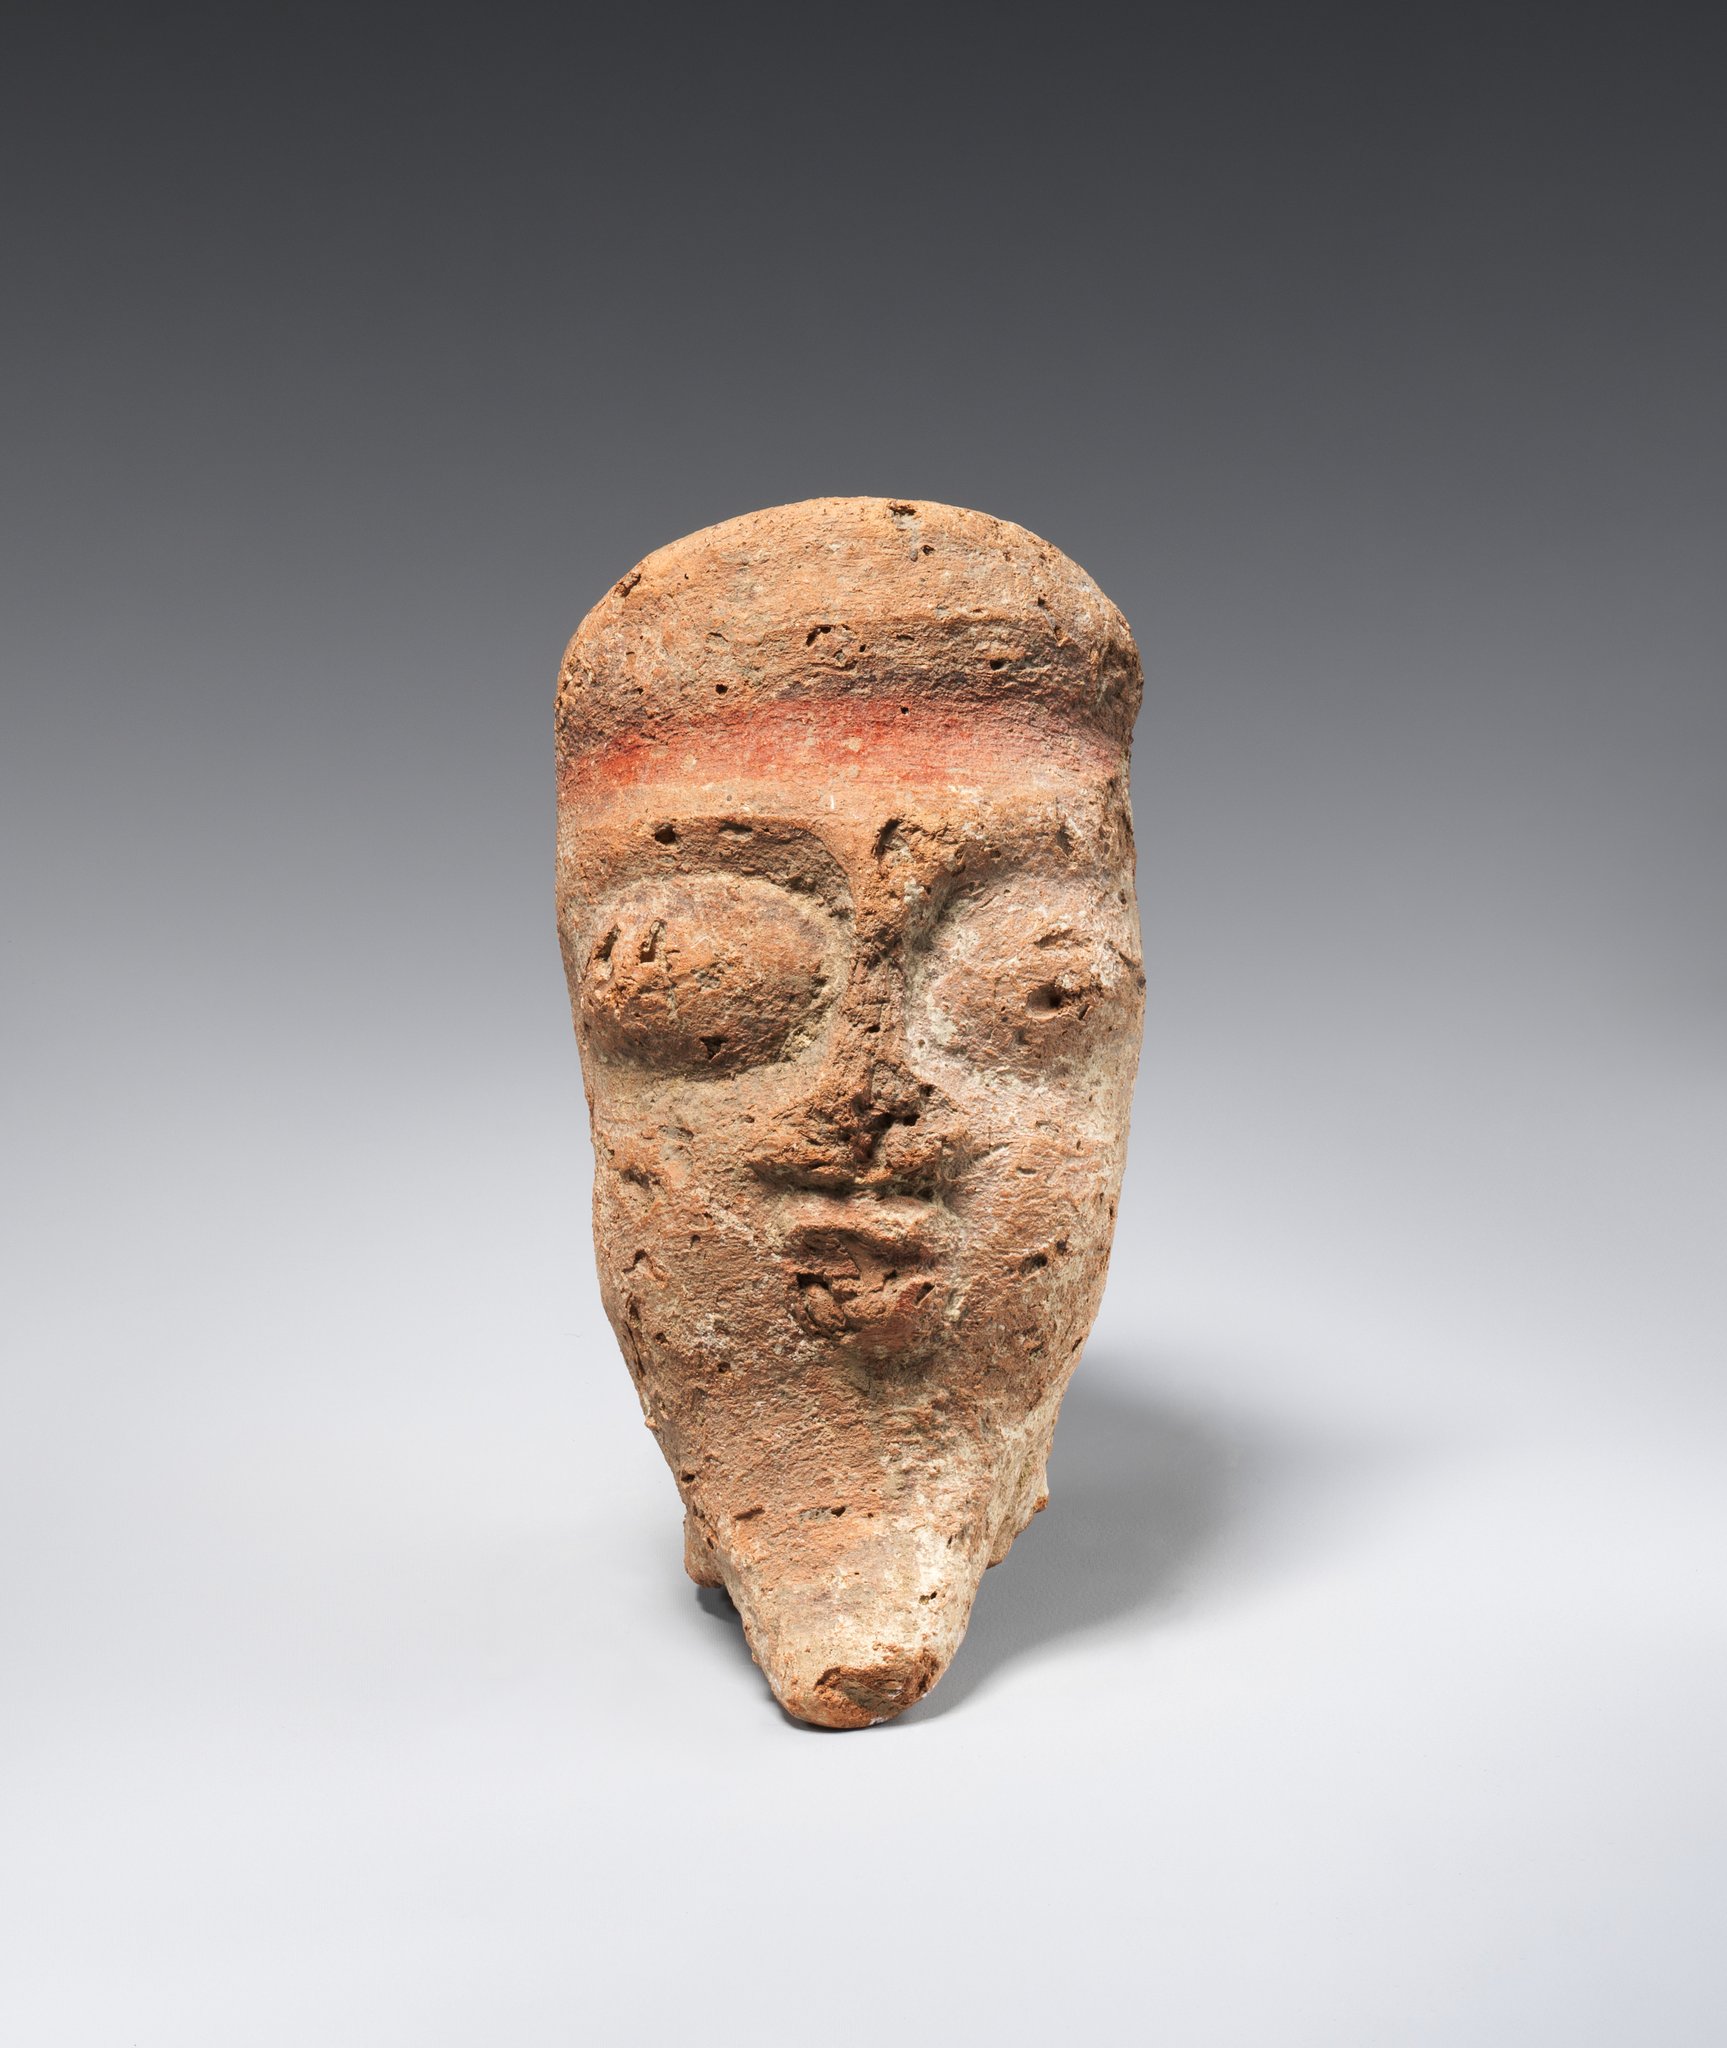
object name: head fragment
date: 332-330 BCE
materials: paint, pottery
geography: egypt